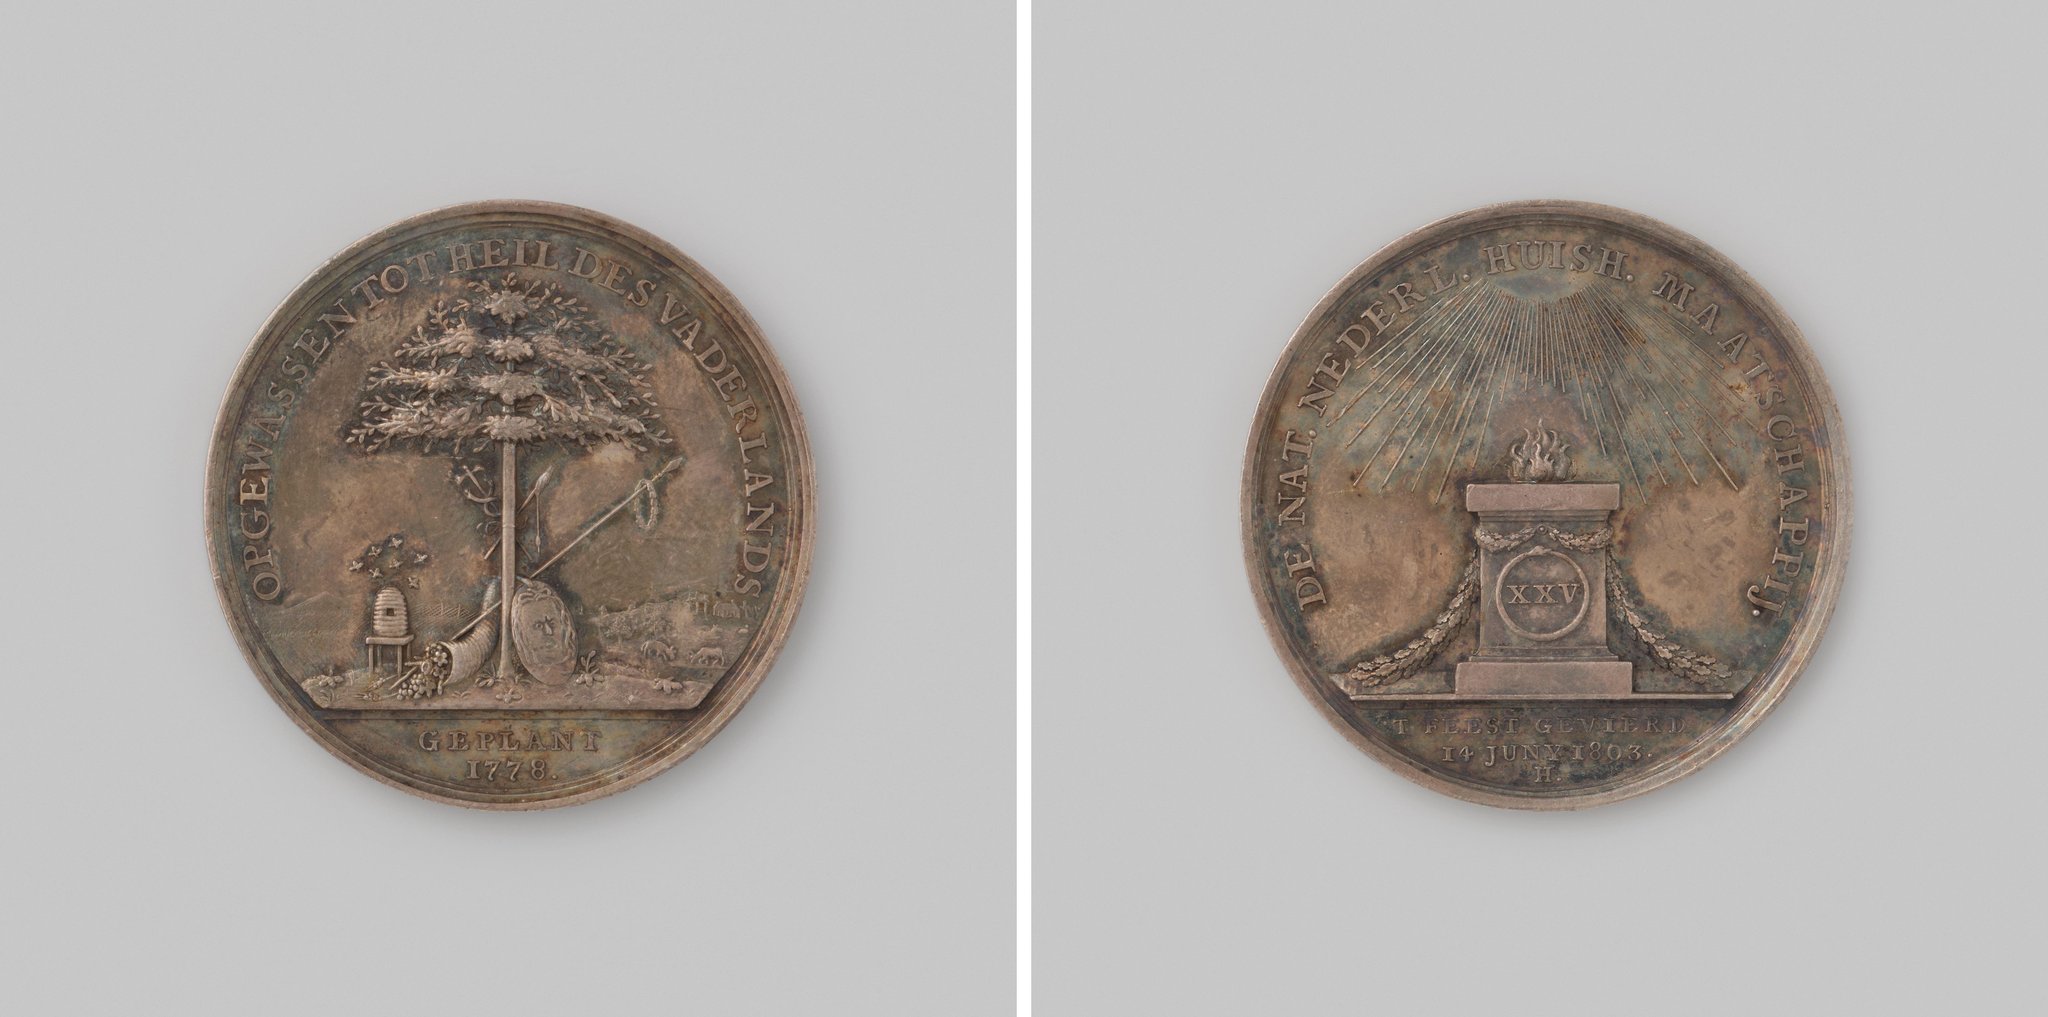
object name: history medal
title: Vijfentwintigjarig bestaan van de Nationale Nederlandsche Huishoudkundige Maatschappij 1803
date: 1803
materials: silver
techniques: striking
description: Zilveren penning, op de voorzijde een boom te midden van symbolen van handel en nijverheid, met omschrift en afsnedetekst, op de keerzijde een versierd brandend altaar, waarop XXV in slangenrond, onder een stralende zon, met omschrift en afsnedetekst.